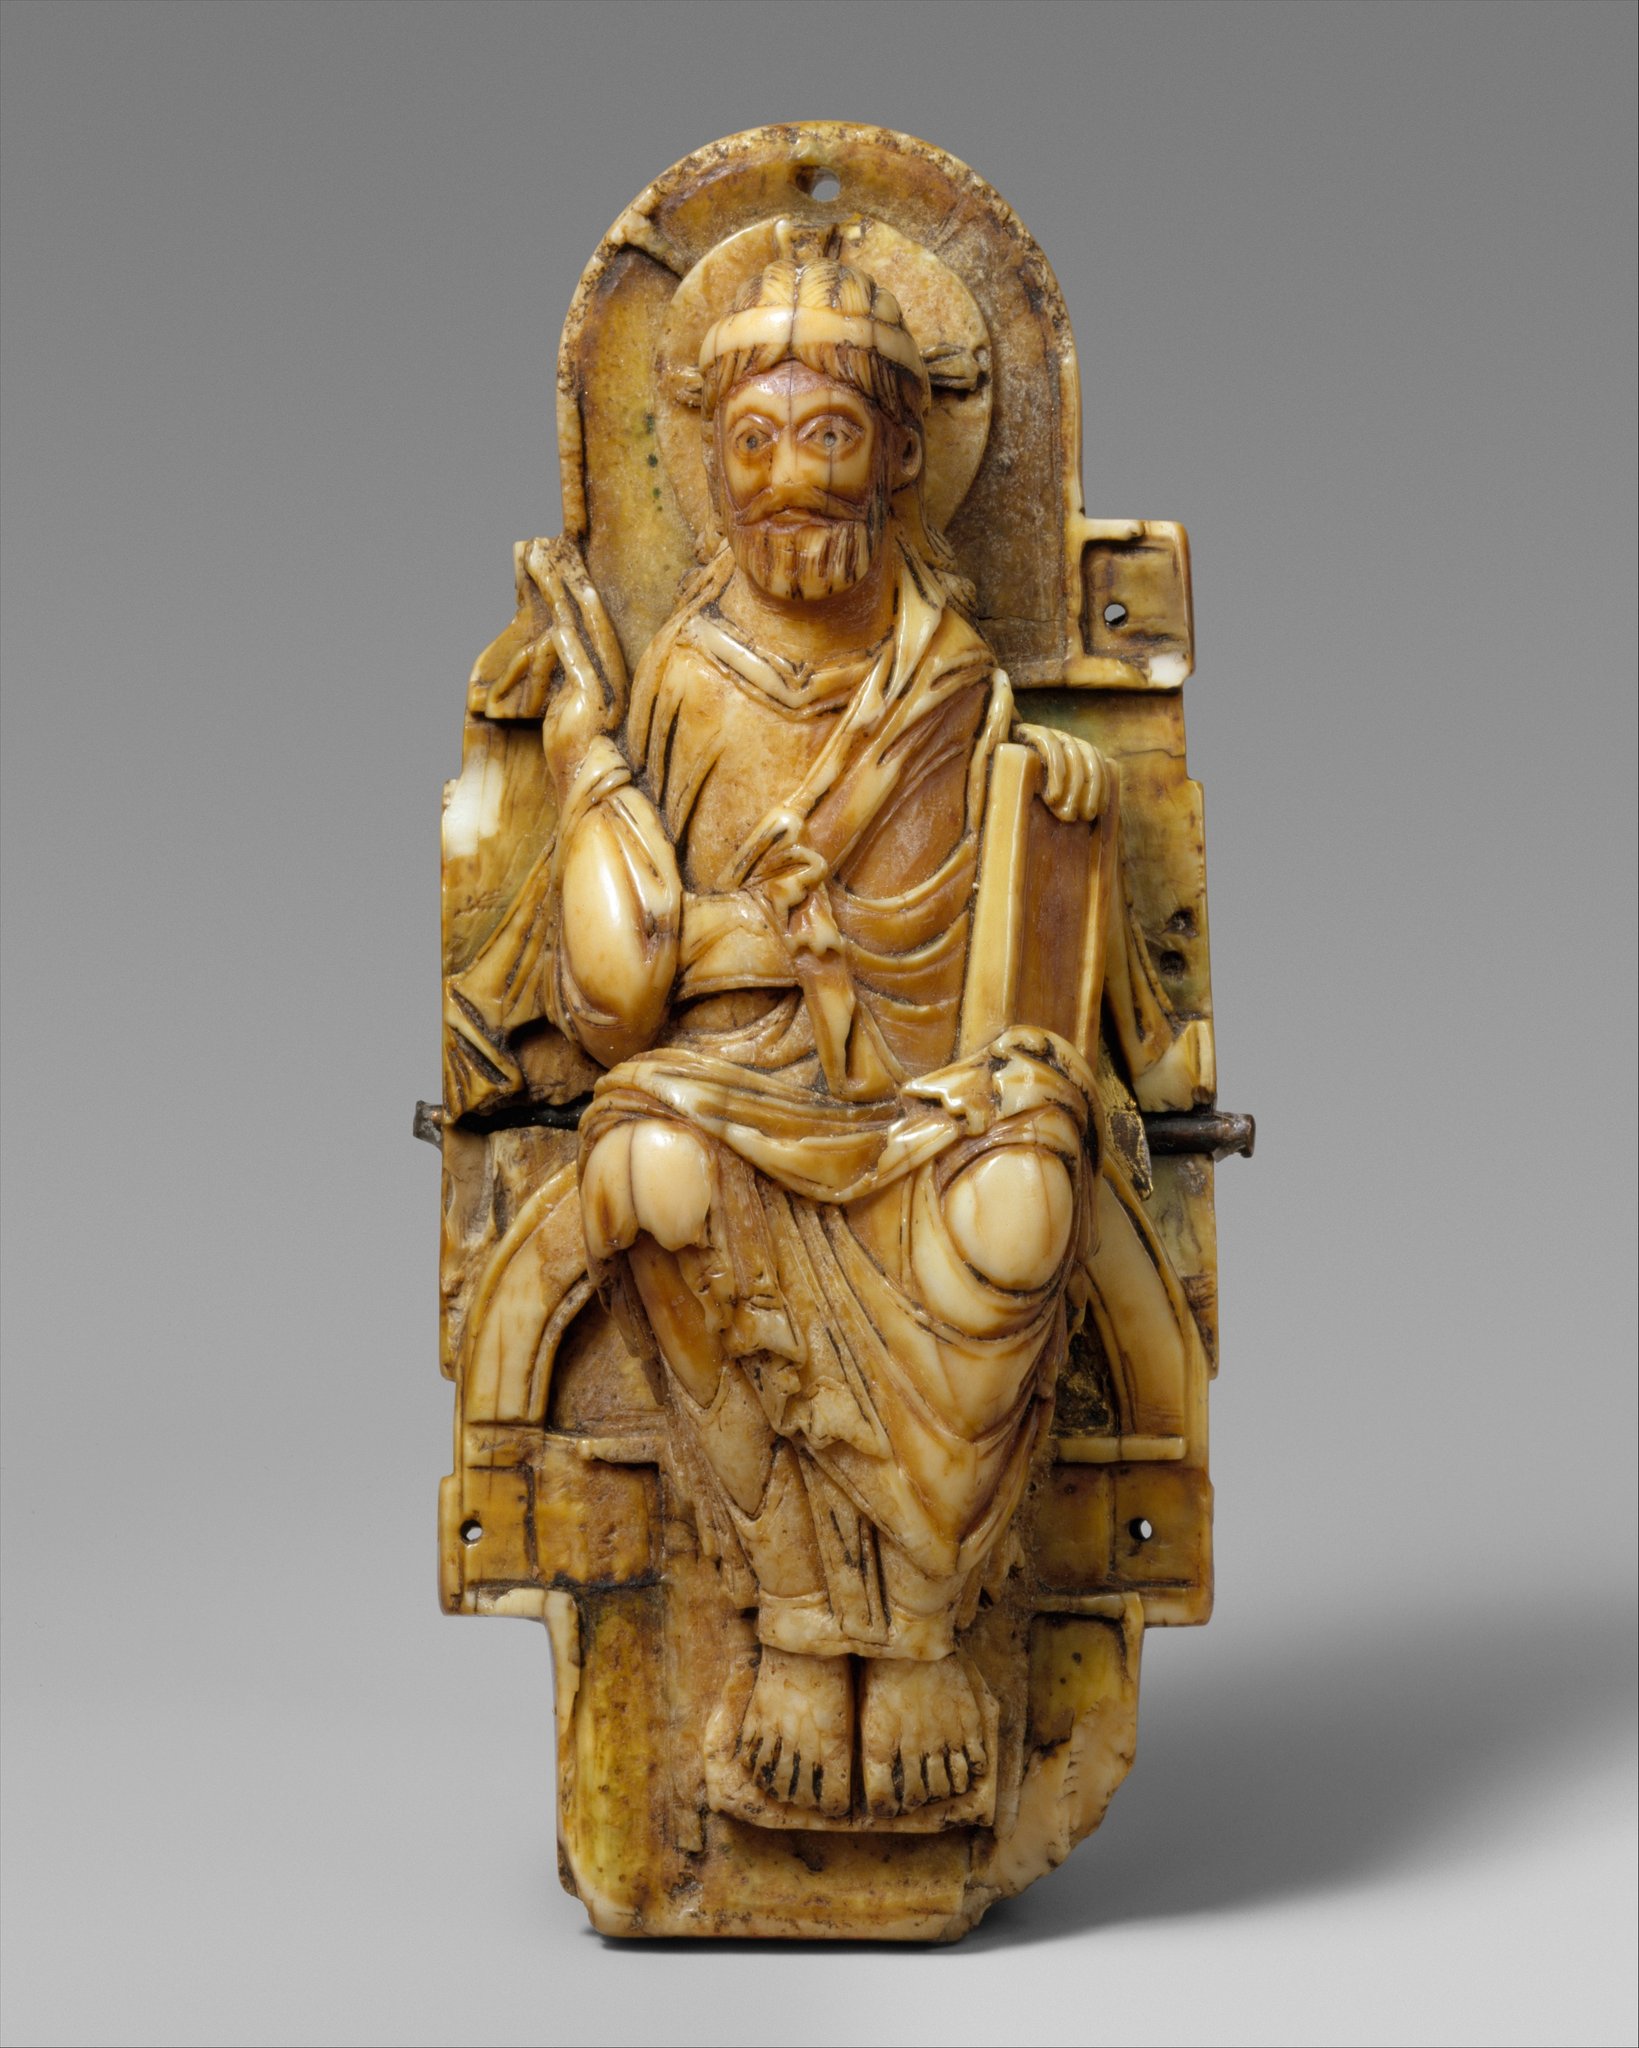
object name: pectoral cross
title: Pectoral with Christ and the Lamb of God and the Symbols of the Four Evangelists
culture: british or north french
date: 1000-1050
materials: copper alloy, copper gilt, ivory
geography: near saint-omer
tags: eagles,lambs,christ,ox